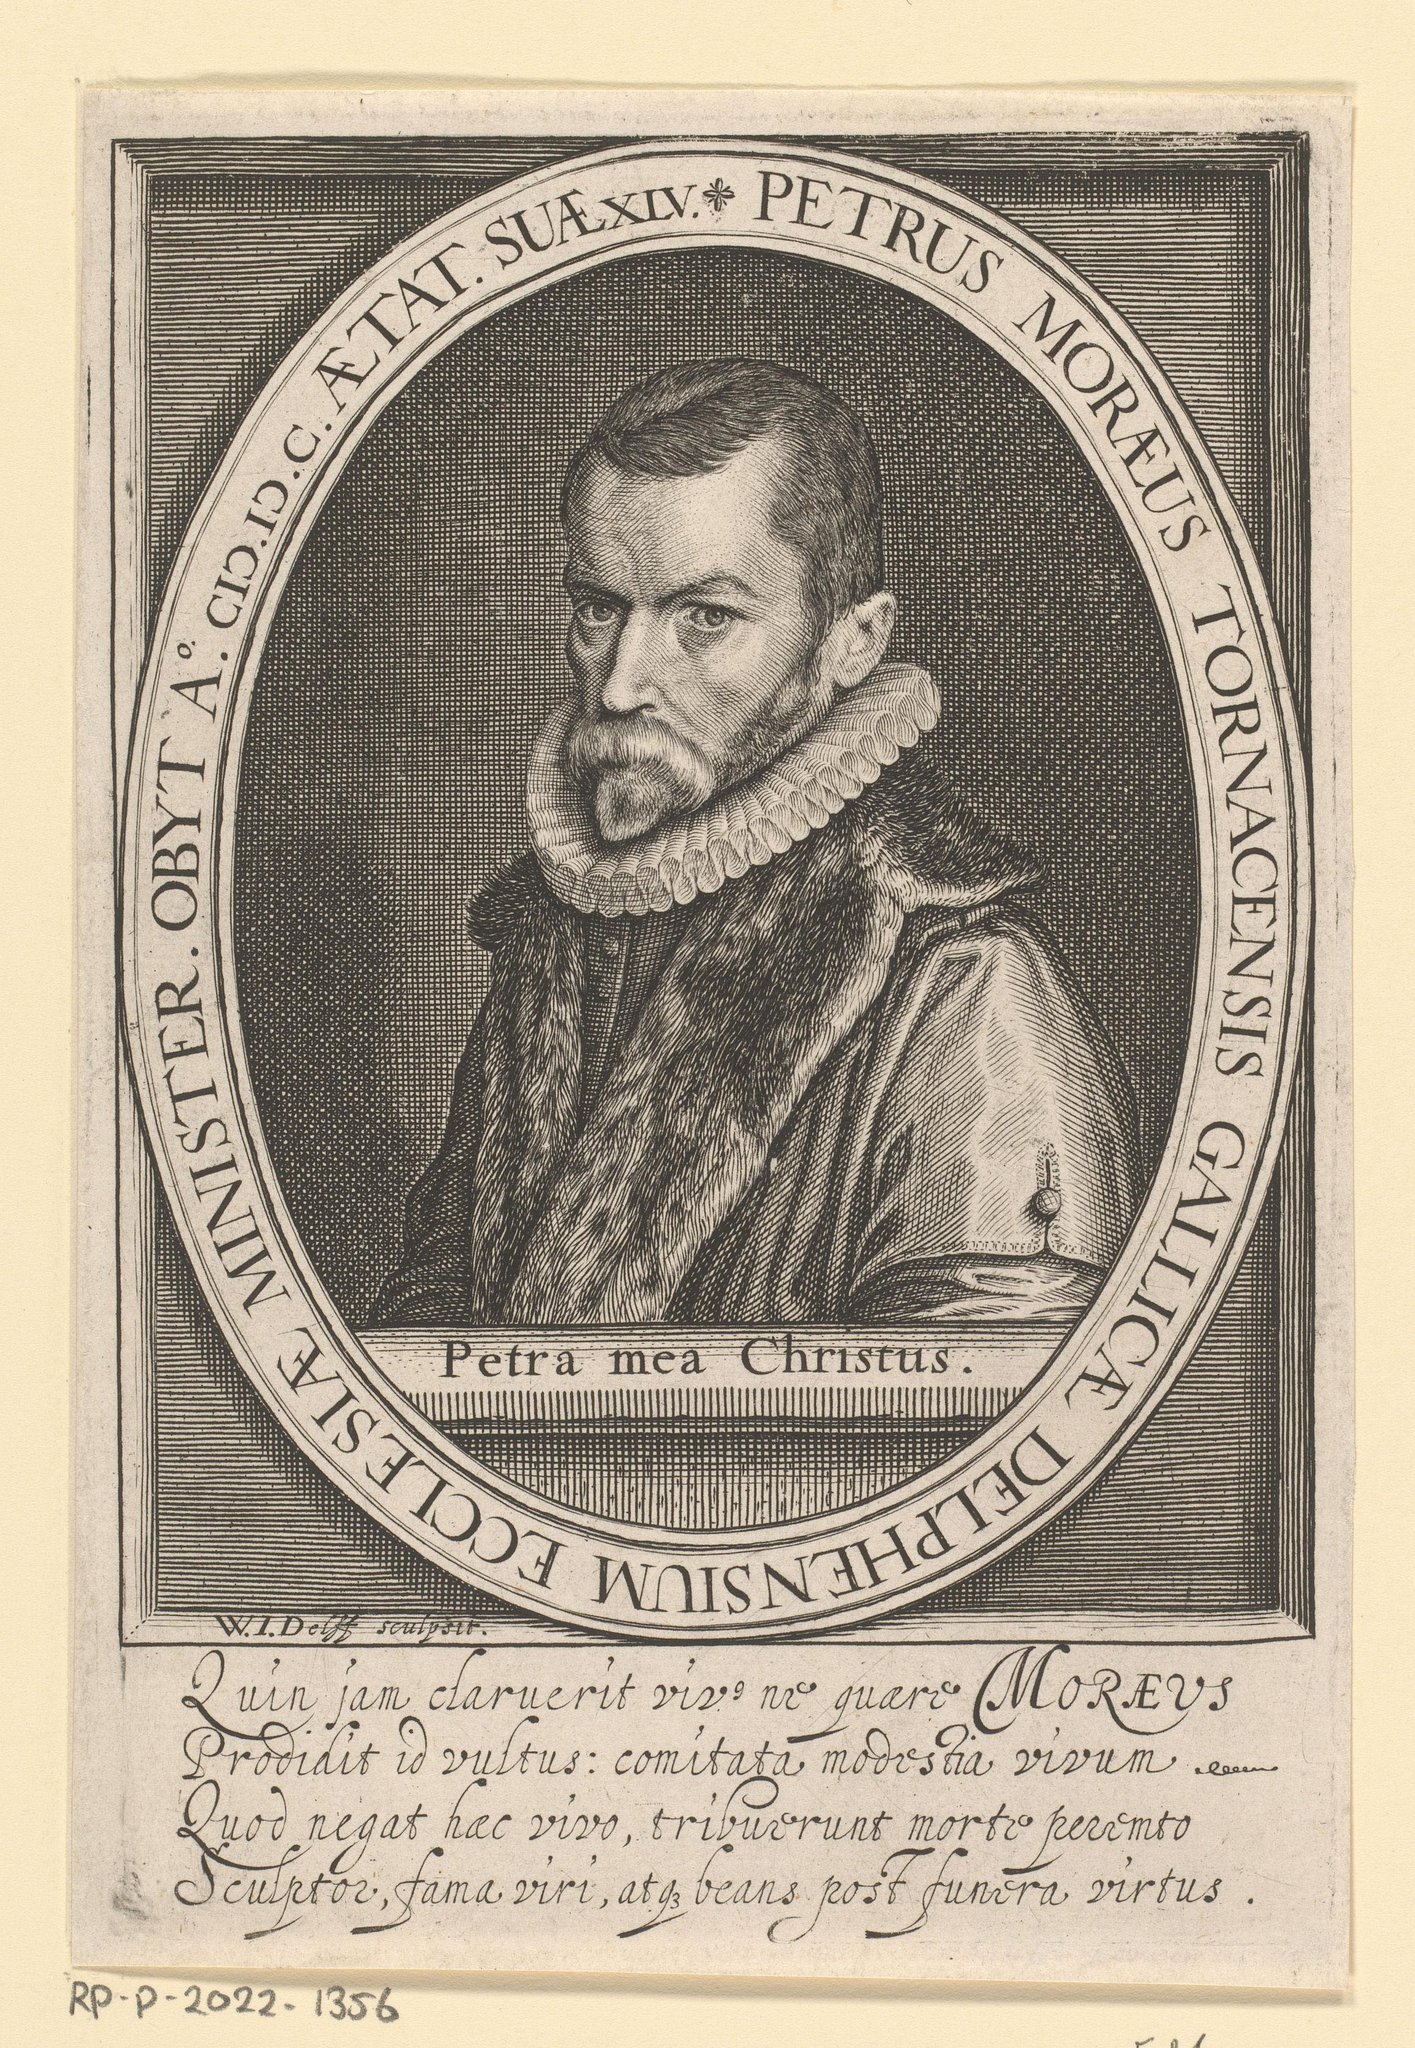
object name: print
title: Portret van Petrus Moraeus op 45-jarige leeftijd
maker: willem jacobsz delff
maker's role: draughtsman, print maker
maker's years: 1580-1638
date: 1600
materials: paper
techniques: engraving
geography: delft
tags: petrus moraeus, historical persons, functionaries and dignitaries (with name) ~ episcopal protestant churches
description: Met vierregelig onderschrift in het Latijn.